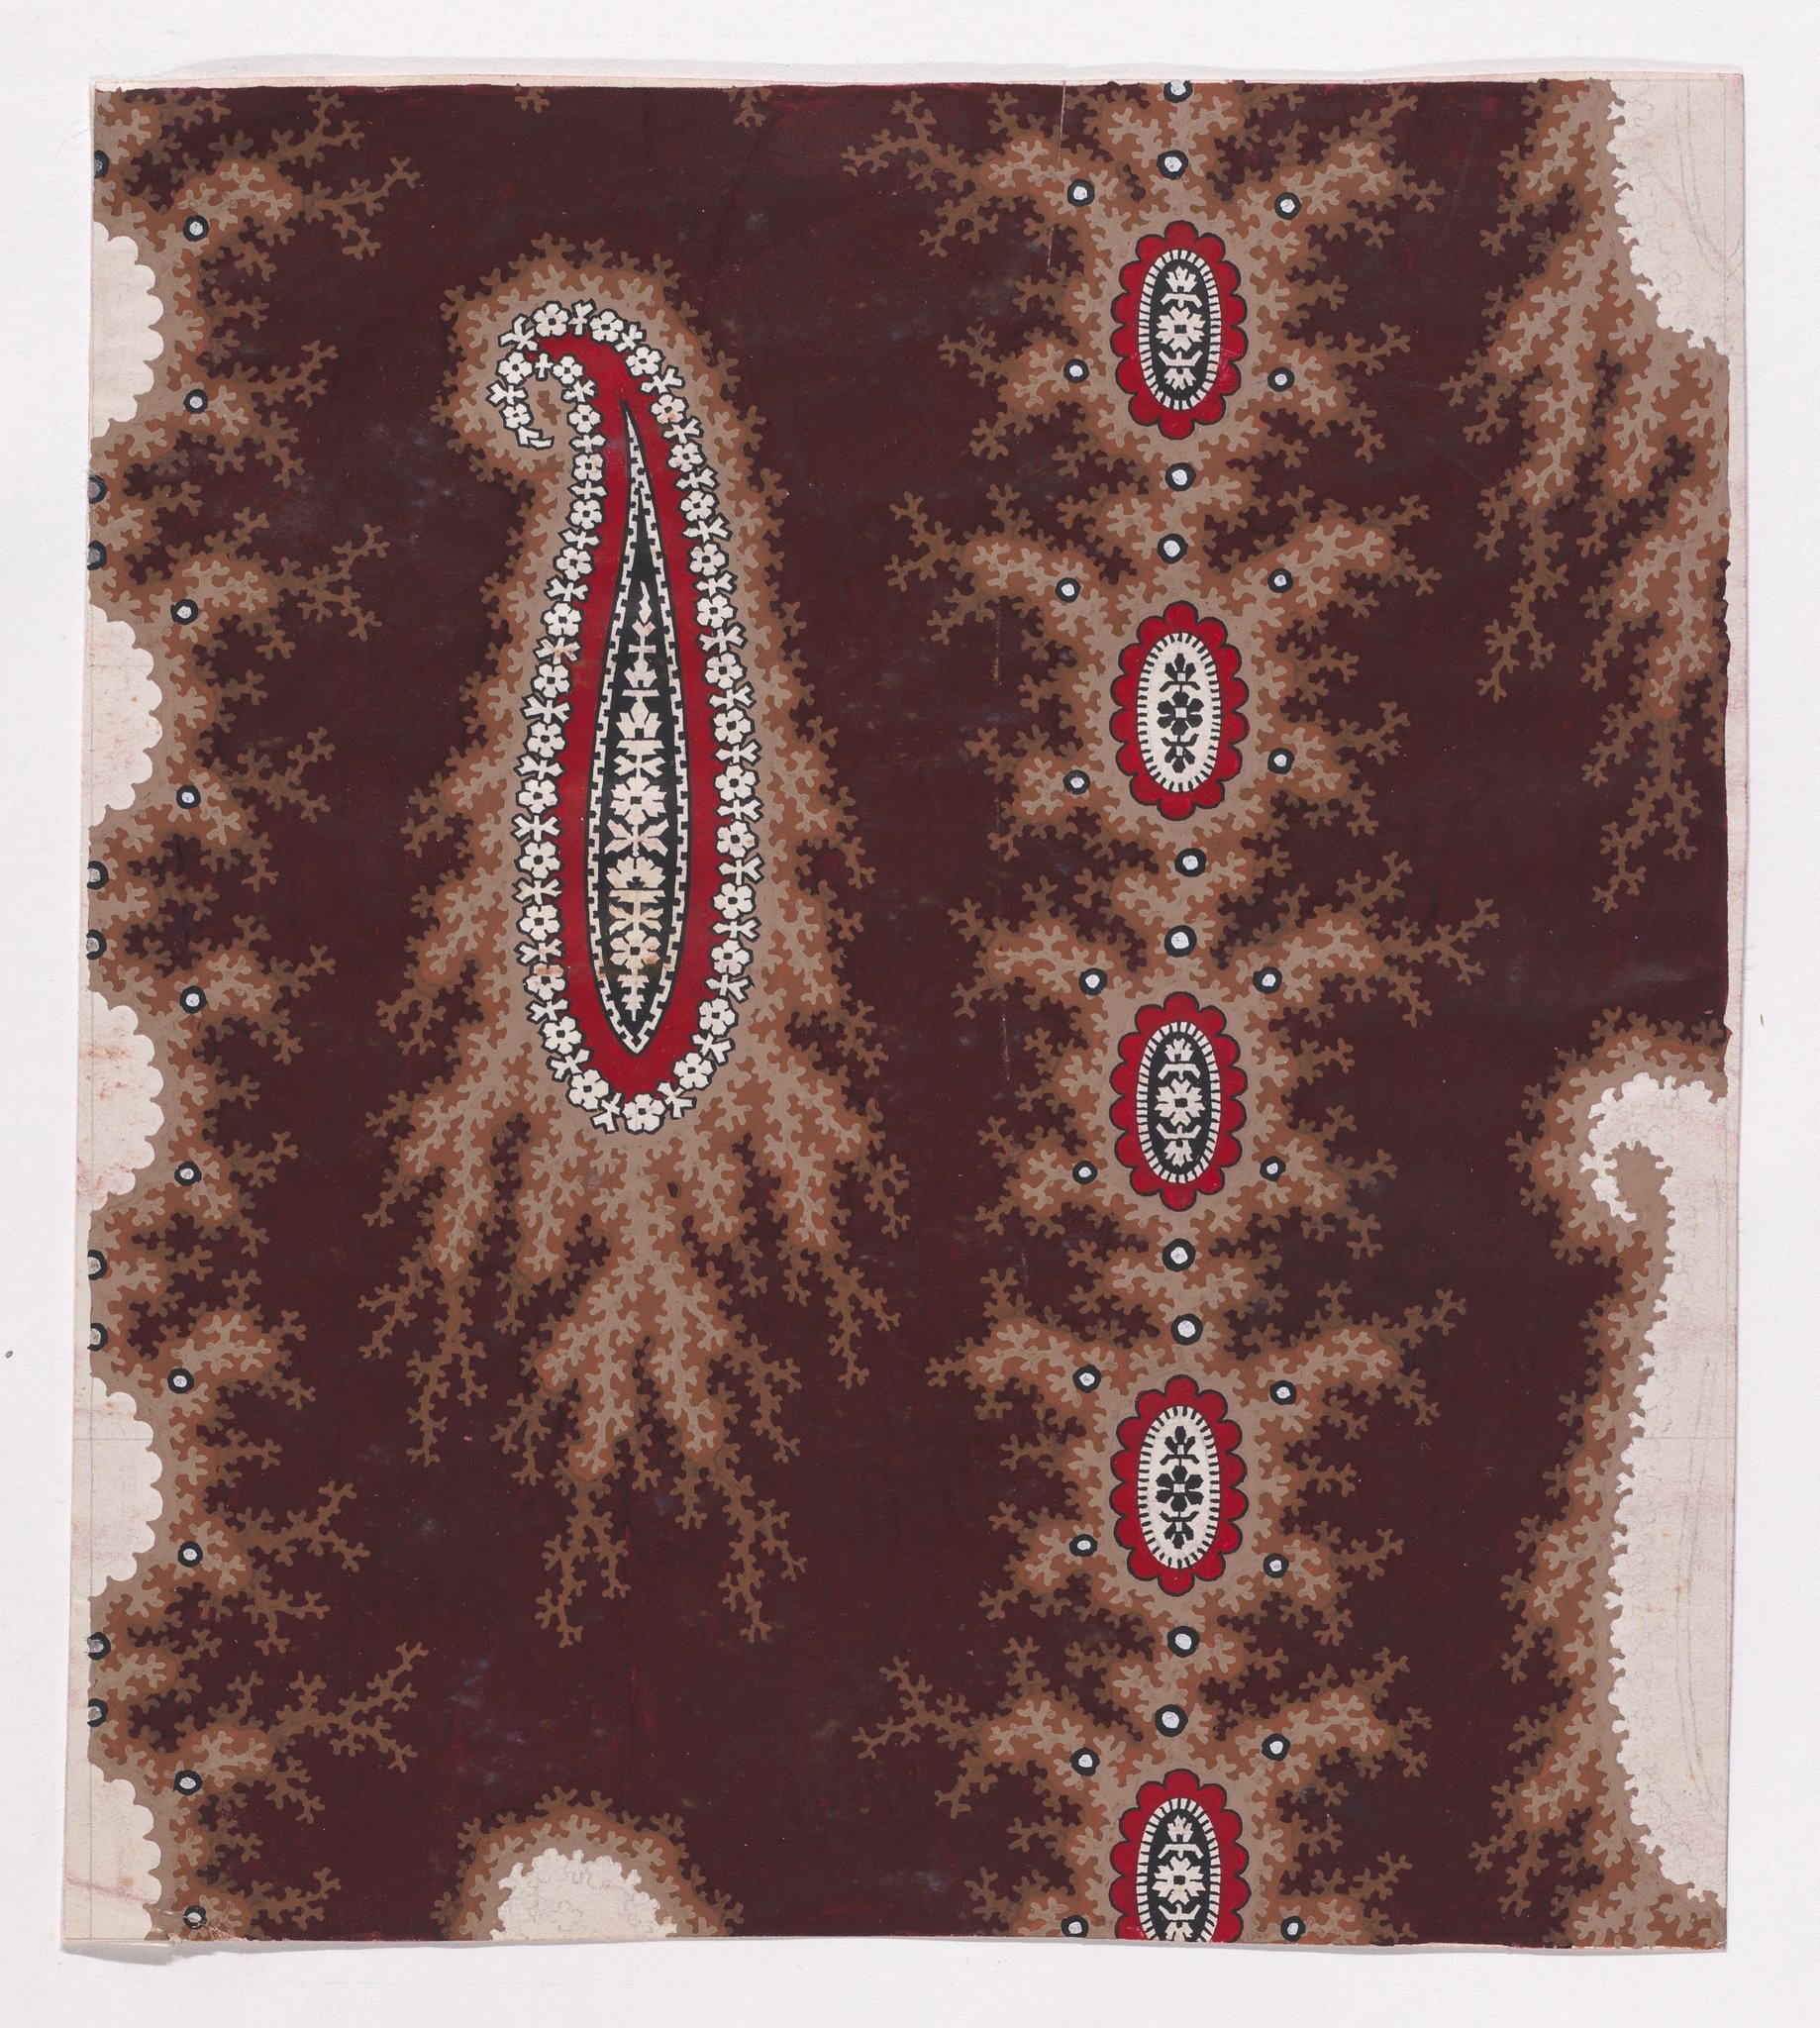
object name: drawing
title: Designs for Printed Cotton Textiles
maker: anonymous, alsatian, 19th century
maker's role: artist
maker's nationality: alsatian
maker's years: 1800-1900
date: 1840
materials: gouache